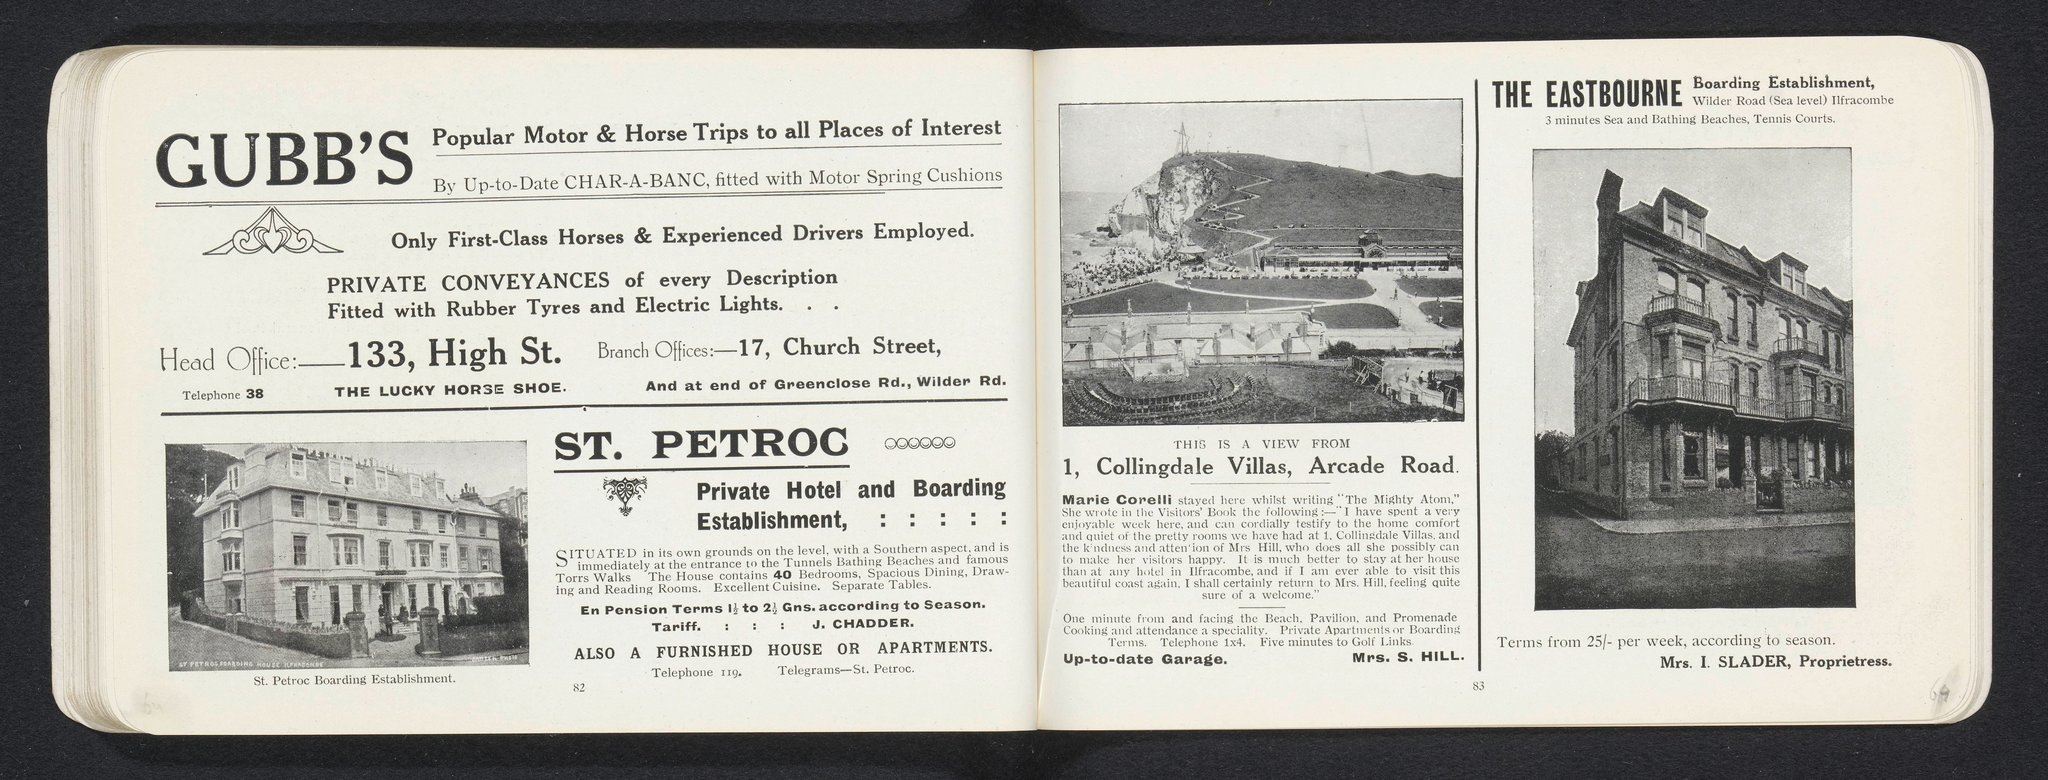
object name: photomechanical print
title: Gezicht op Capstone Hill te Ilfracombe en de voorgevel van het Eastbourne Hotel te Ilfracombe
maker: Anonymous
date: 1900-1920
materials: paper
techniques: autotype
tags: (high) hill, façade (of house or building), hotel, hostelry, inn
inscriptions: inscription: ‘This is a view (...) I. Slader, Proprietress.’